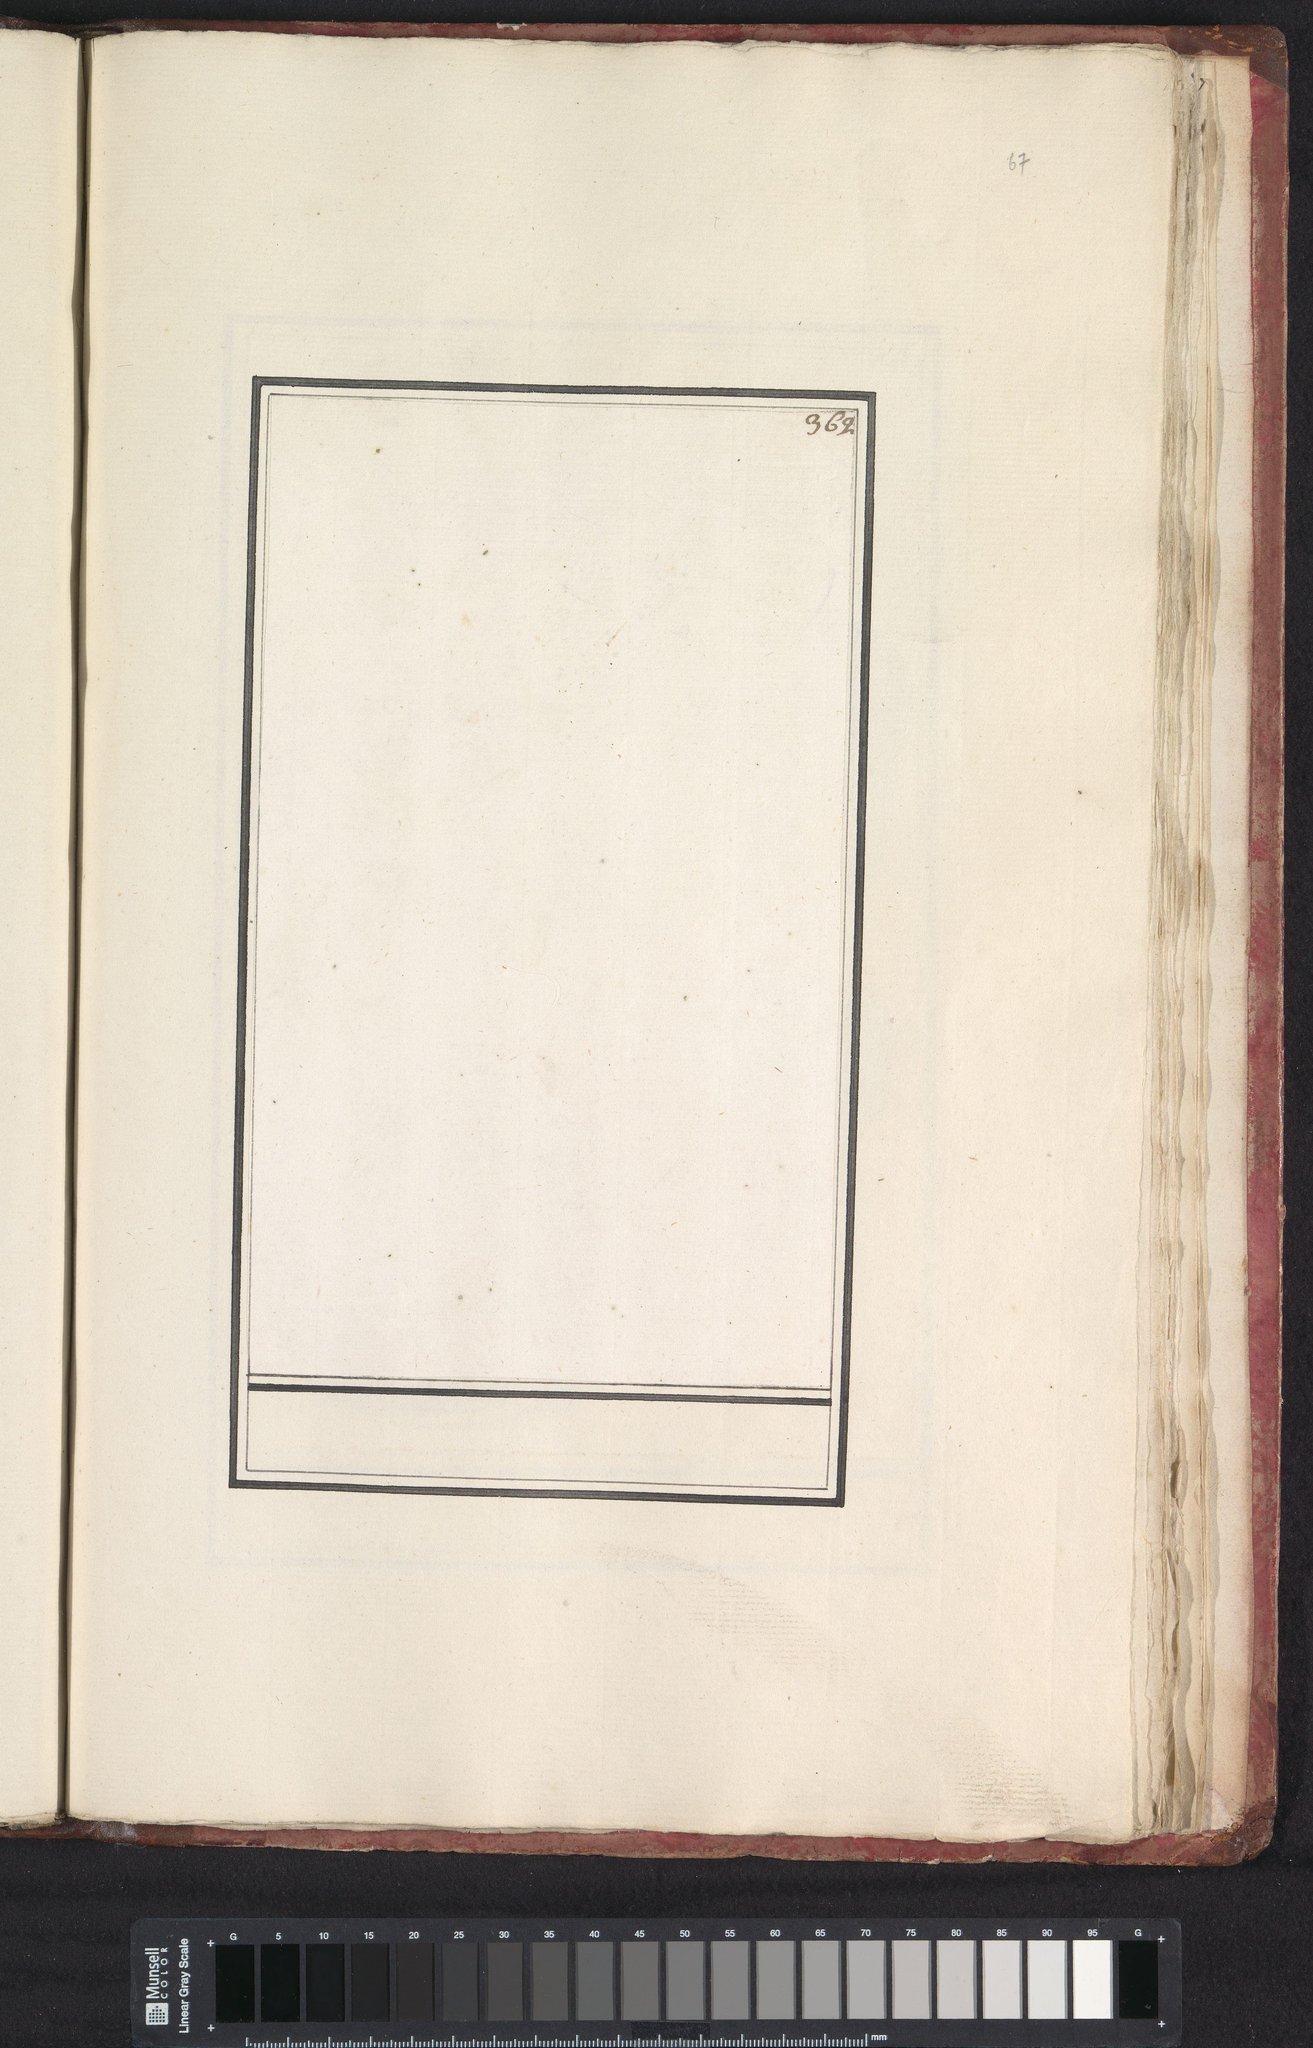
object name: drawing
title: Omlijsting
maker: Anonymous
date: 1809-1814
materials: paper, pencil, watercolor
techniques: brush, pen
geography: southern netherlands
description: Lege omlijsting. Rechtsboven genummerd: 362. Onderdeel van het vierde album met tekeningen van bloemen en paddestoelen. Elfde van twaalf albums met tekeningen van dieren, vogels en planten bekend rond 1600, gemaakt in opdracht van keizer Rudolf II. Met toelichting in Nederlands, Latijn en Frans.